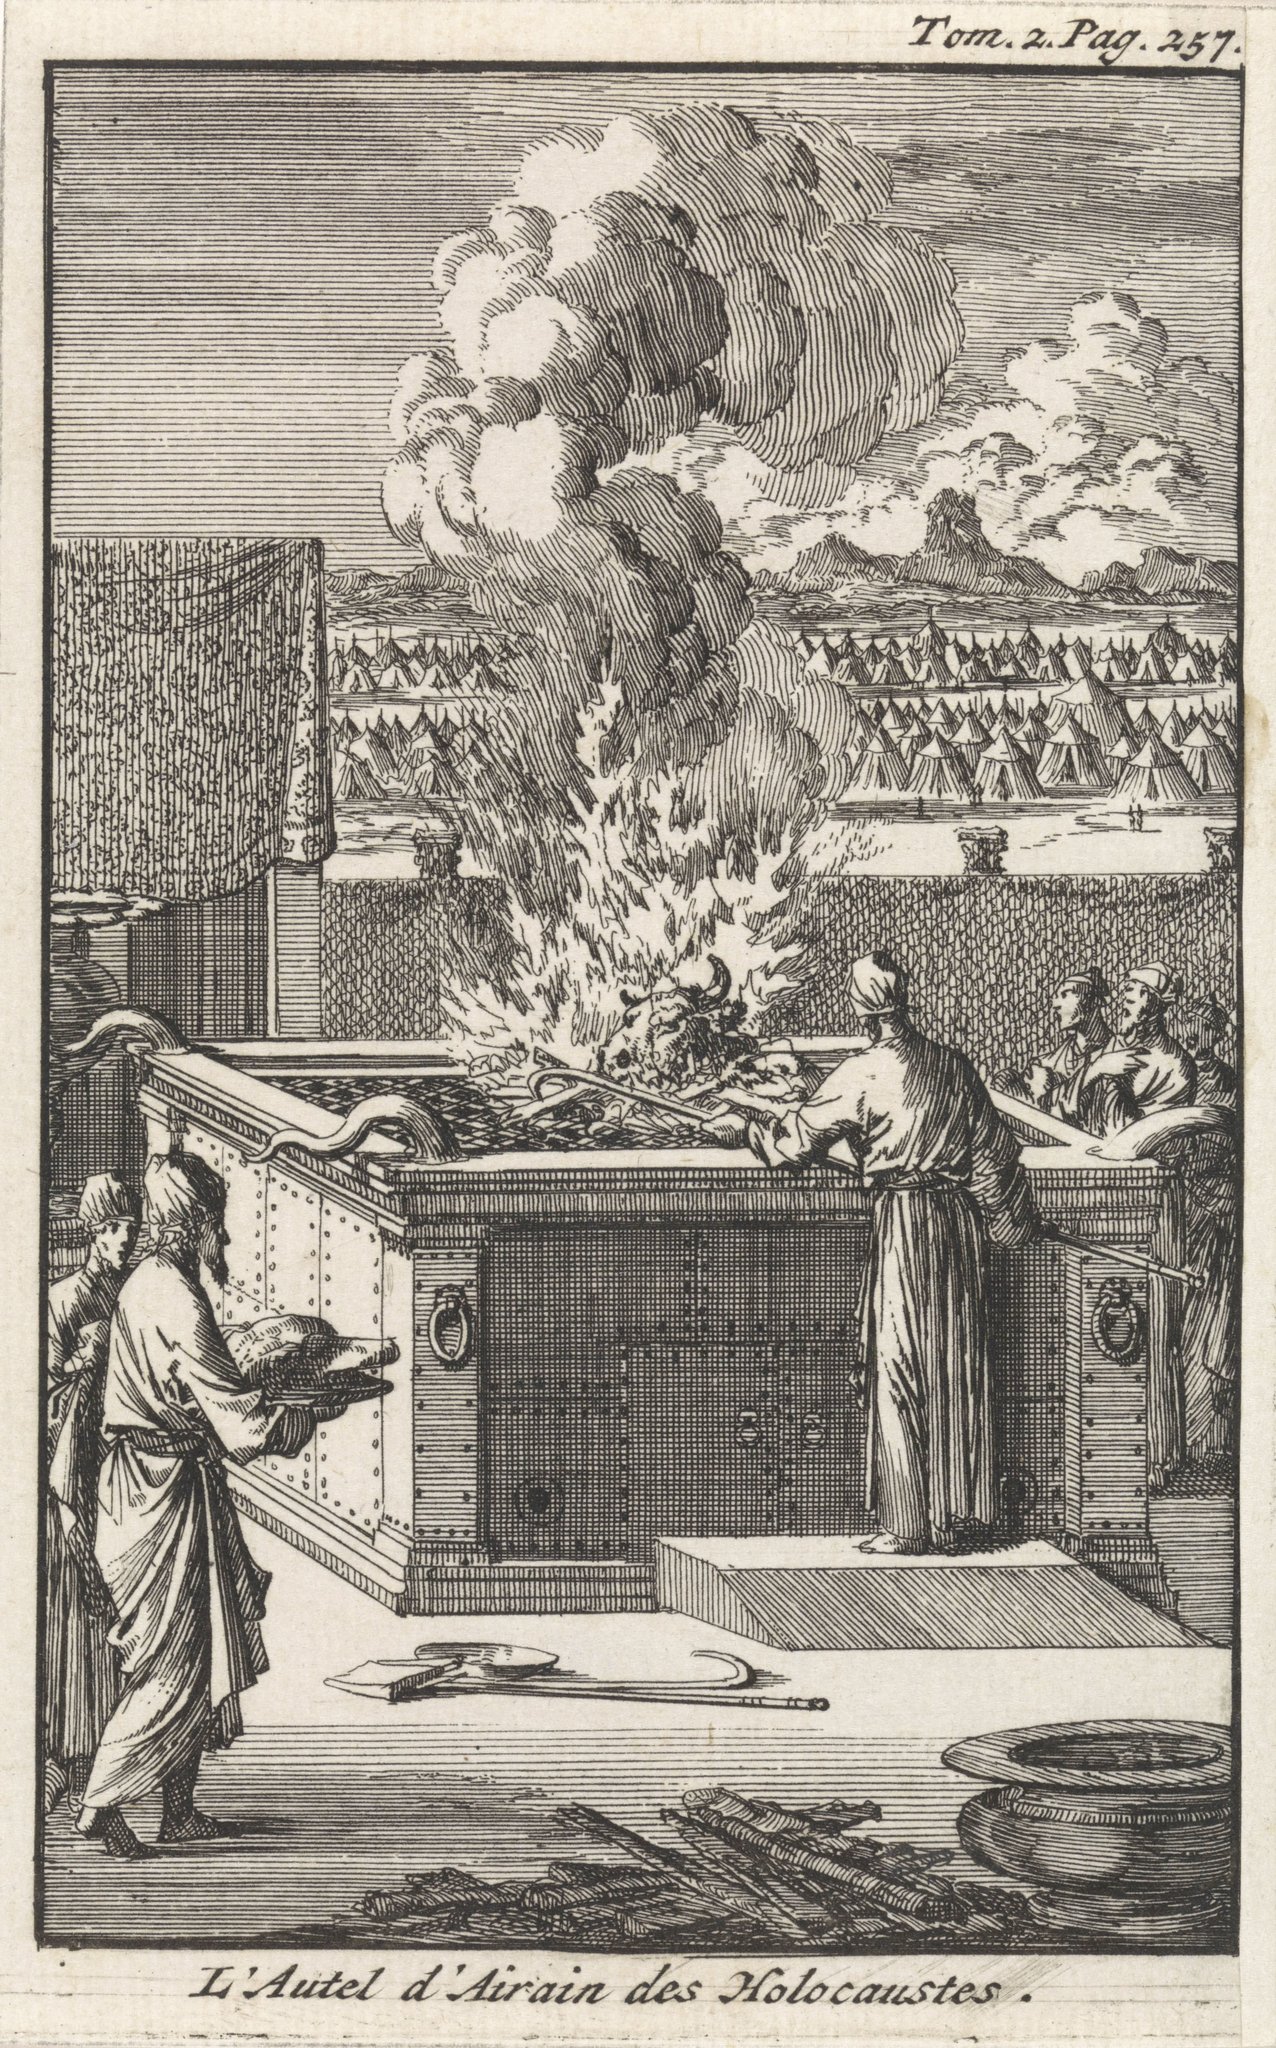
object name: book illustration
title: Priester offert stier op het brandofferaltaar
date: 1705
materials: paper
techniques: etching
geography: amsterdam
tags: the altar of burnt offering, the brazen altar ~ jewish religion, the court of the tabernacle ~ jewish religion, sacrifice of animals ~ jewish religion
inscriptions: collector's mark: Lugt 2228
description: Illustratie uit: Cunaeus, Petrus. La republique des Hebreux, 3 delen. Amsterdam: Pieter Mortier, 1705, dl. II, p. 257.